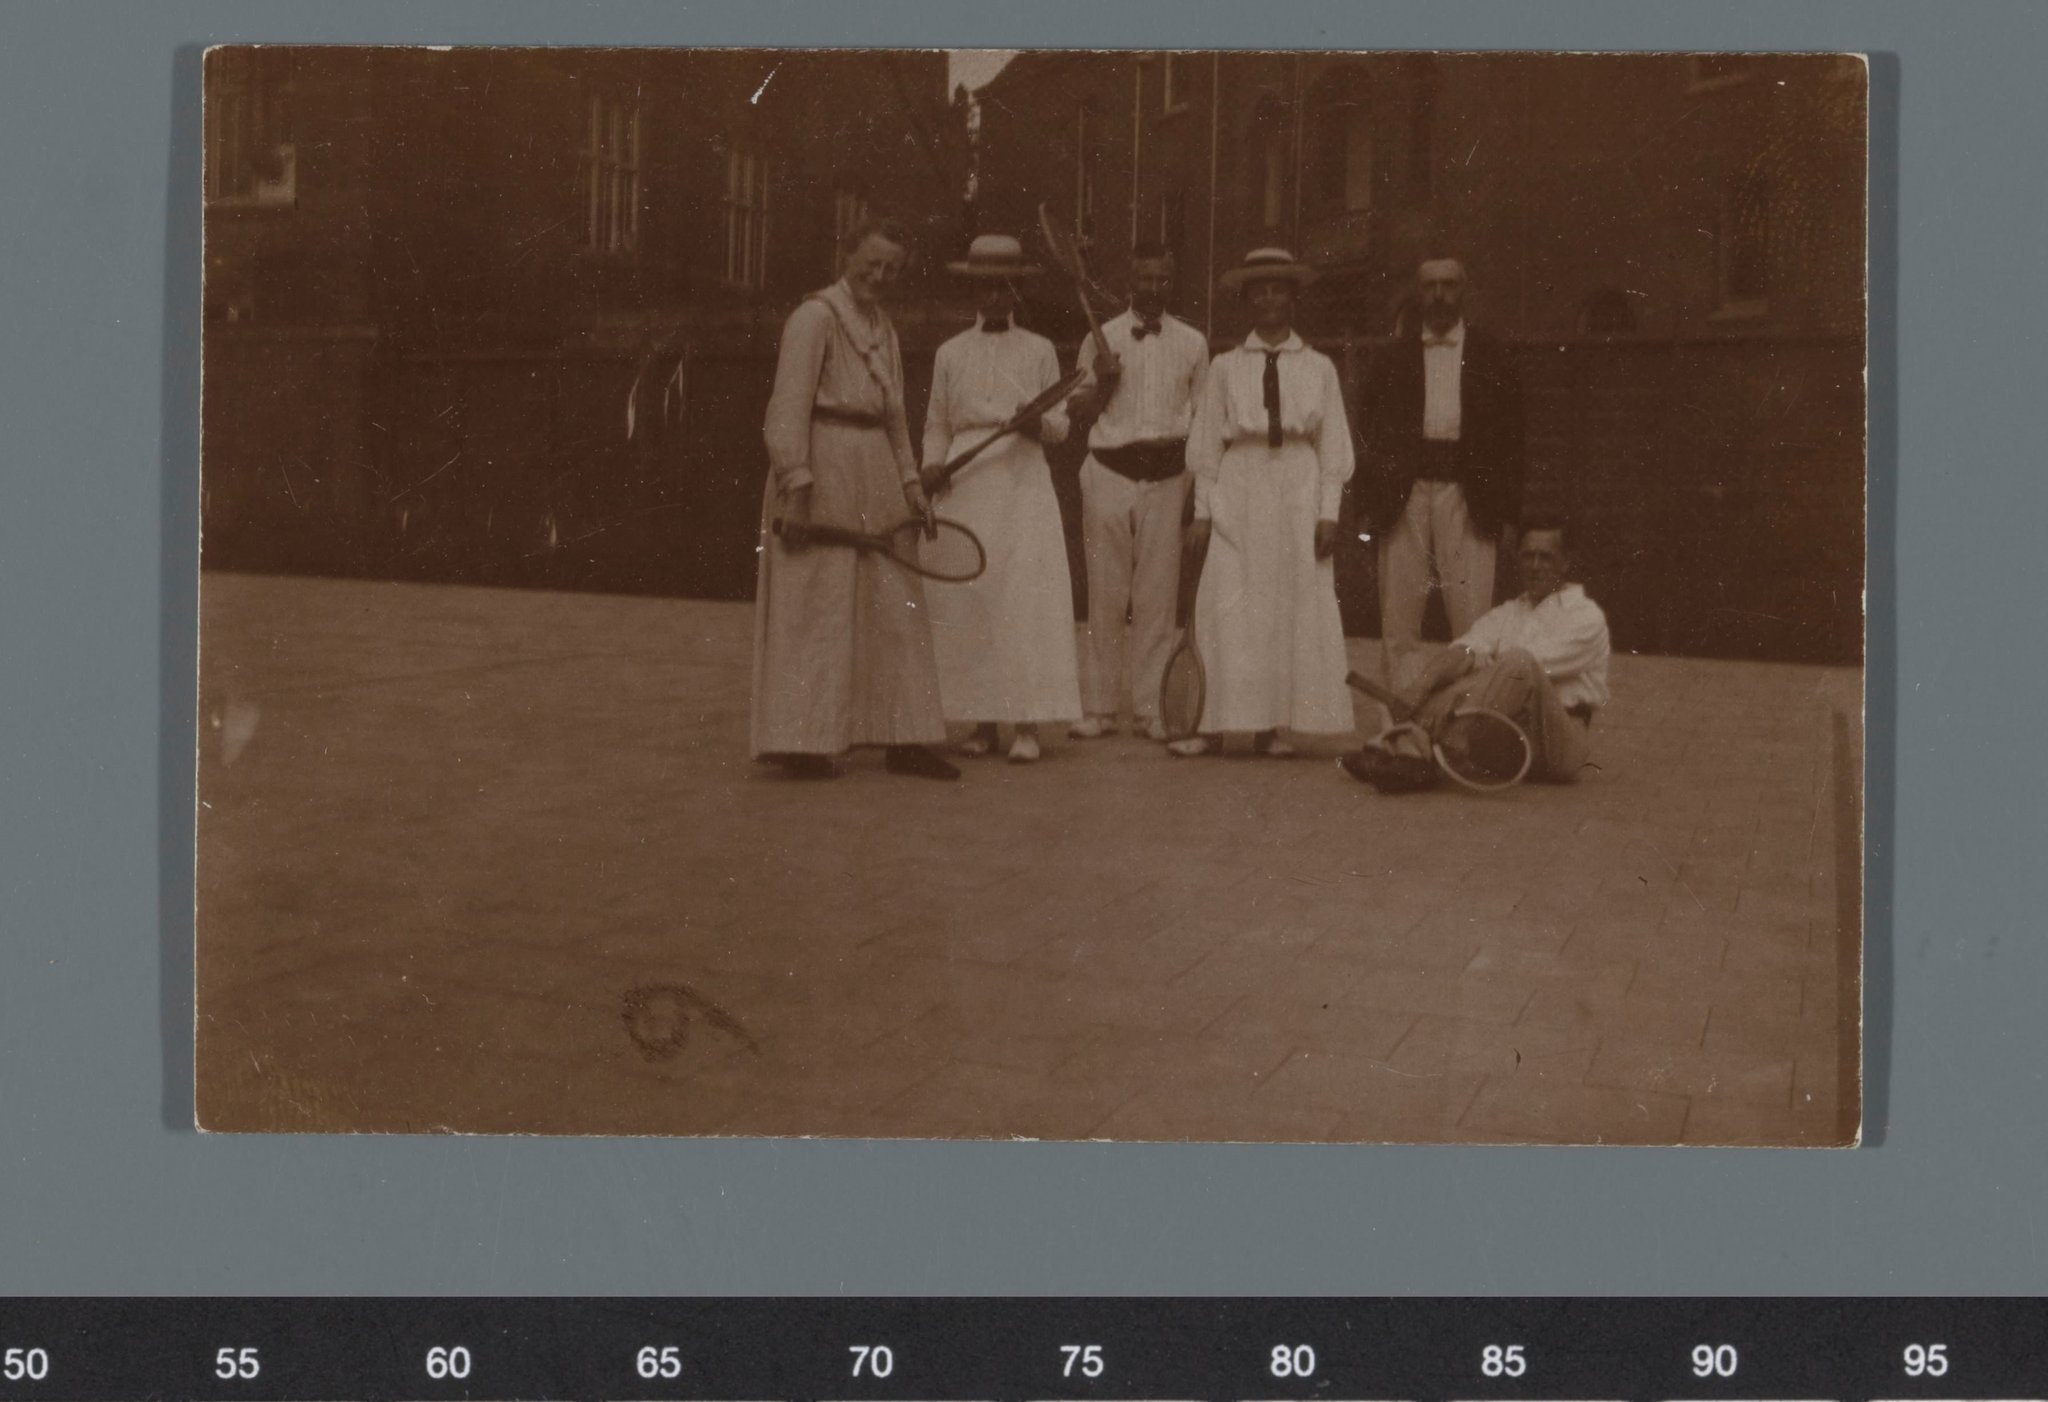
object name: photograph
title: Groepsportret van een gezelschap met tennisrackets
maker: cornelia hendrika jonker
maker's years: 1874-1924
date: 1917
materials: photographic support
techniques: collodion silver print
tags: tennis, lawn-tennis, anonymous historical persons portrayed in a group, in a group-portrait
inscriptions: annotation: ‘1917’